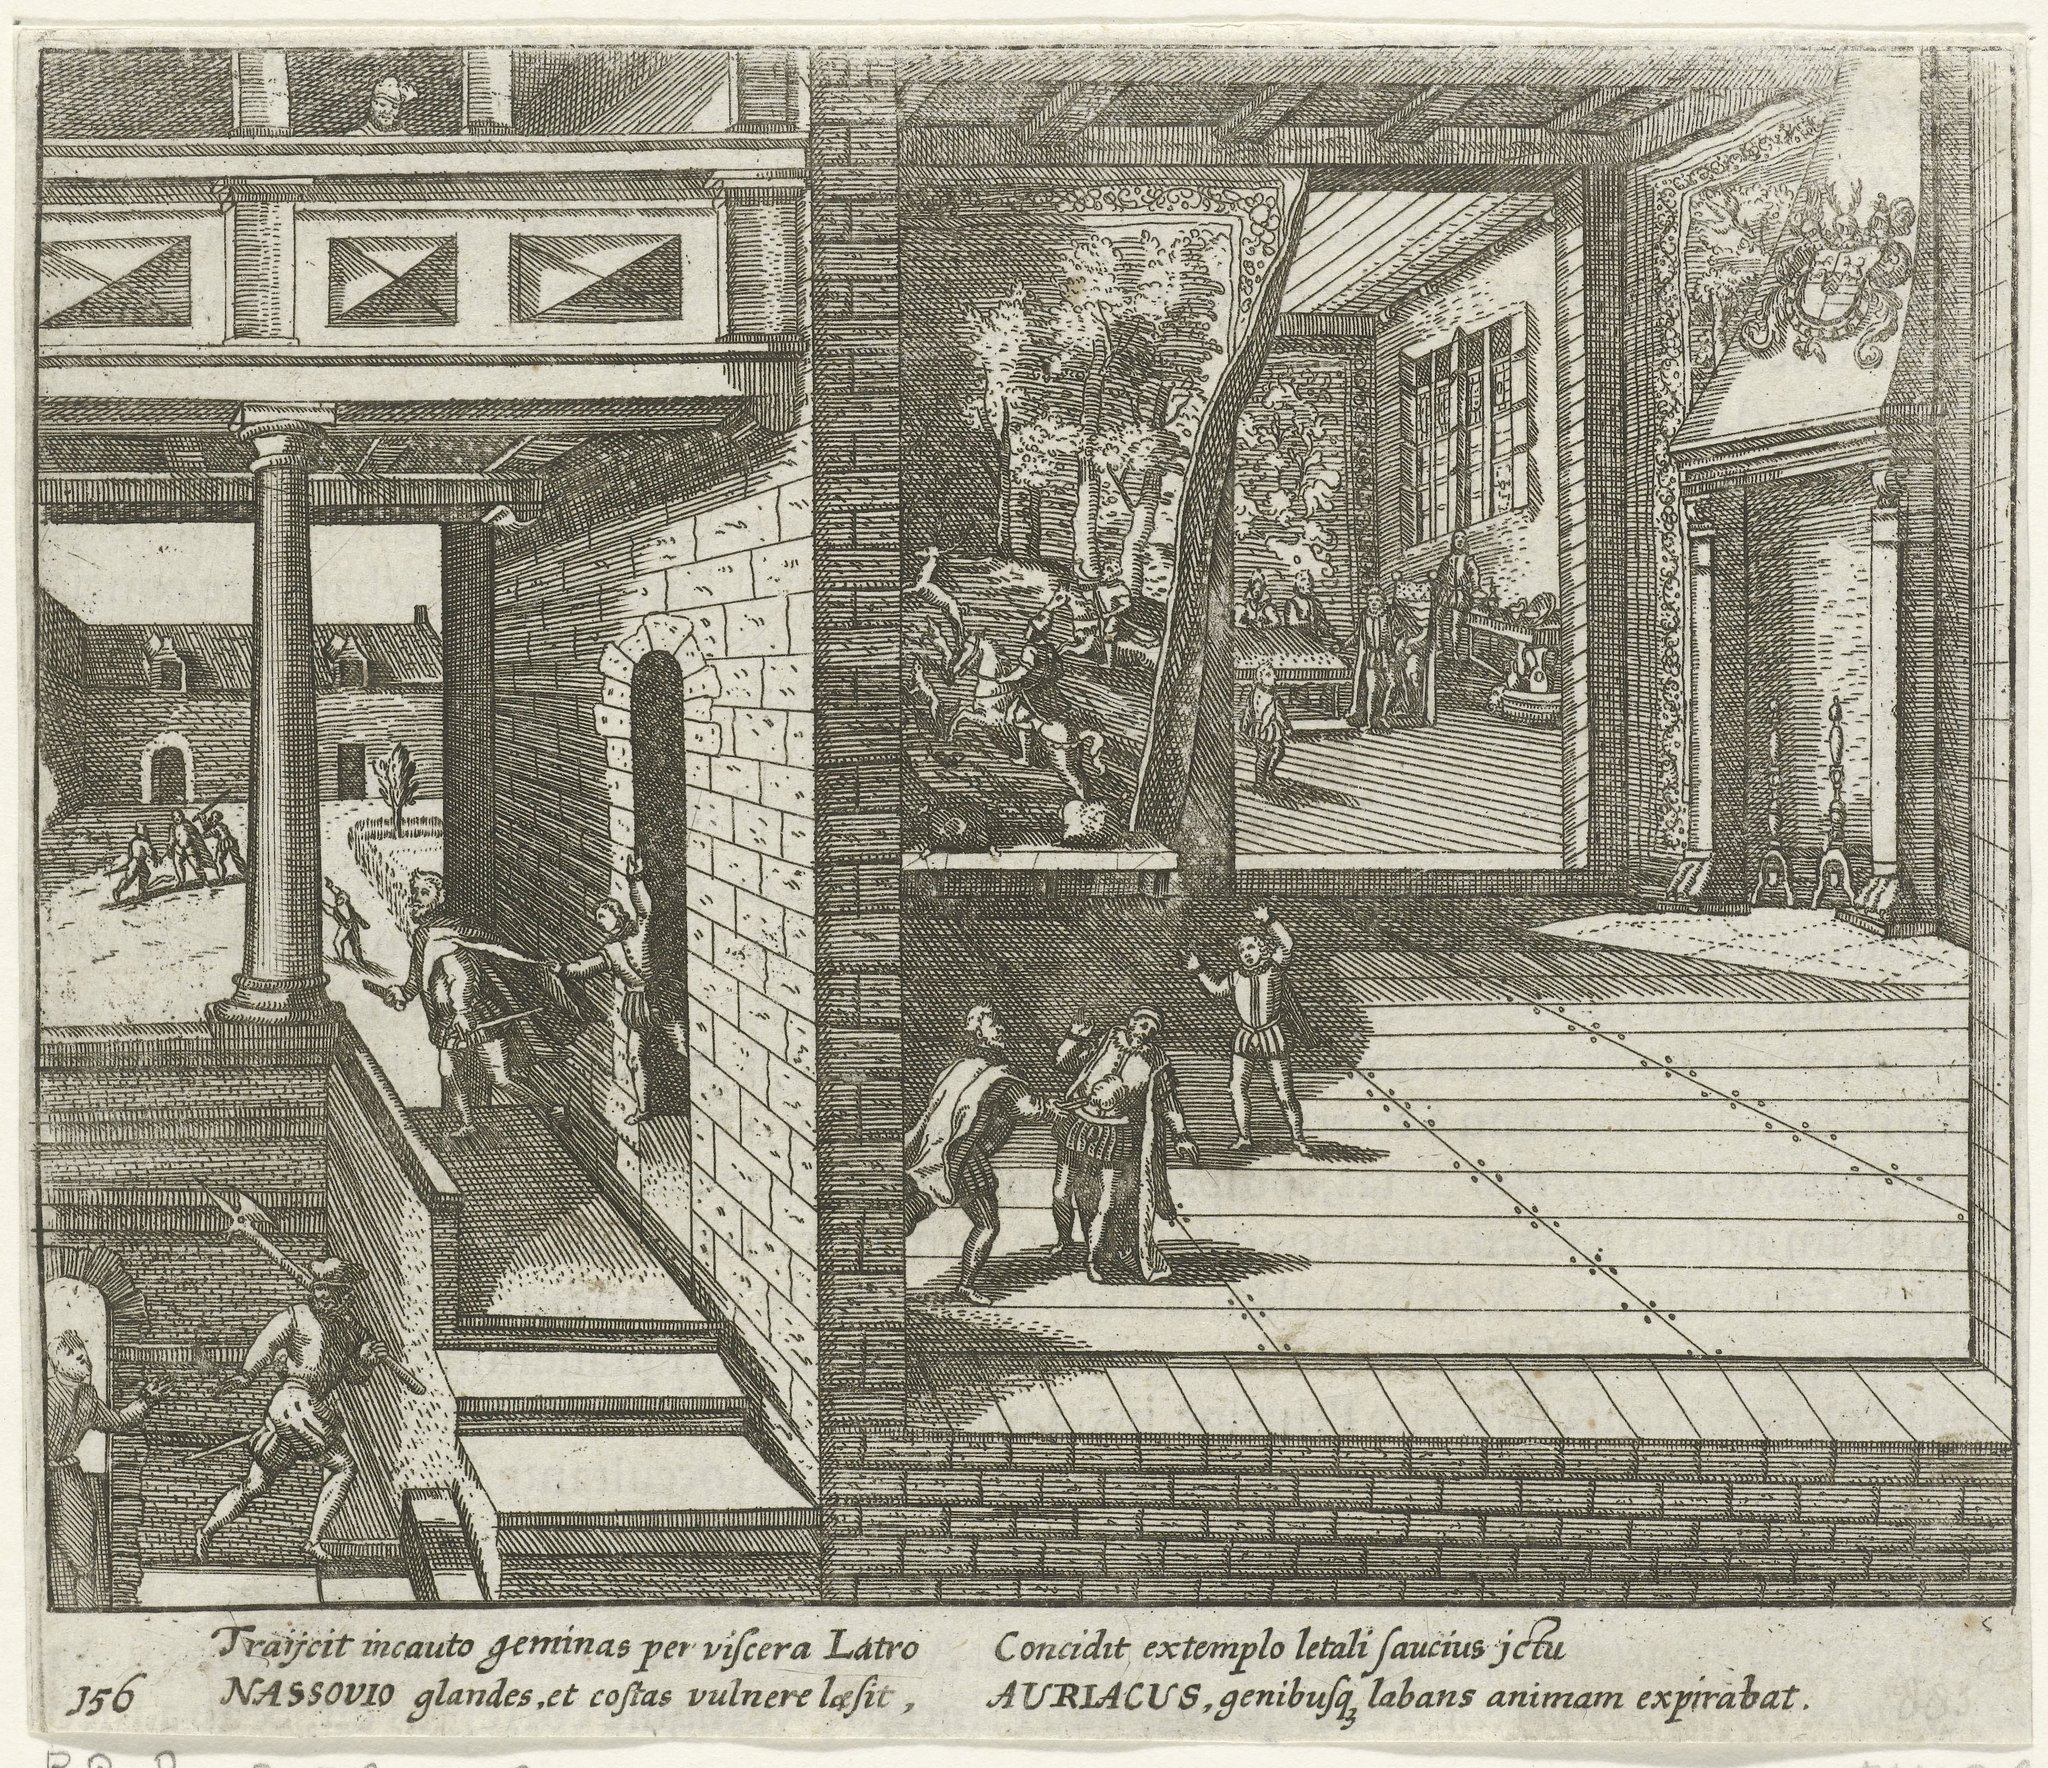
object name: print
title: De moord op Willem van Oranje, 1584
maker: Anonymous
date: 1613-1615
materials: paper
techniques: etching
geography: northern netherlands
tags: delft, william i (prince of orange), attempt, political murder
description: Willem van Oranje vermoord door Balthasar Gerards, 10 juli 1584. Gezicht op interieur Prinsenhof: achter ontvangt de prins Gerards in een kamer, op de voorgrond wordt de prins neergeschoten. Links probeert Gerard te ontsnappen en wordt hij gevangengenomen. Met onderschrift van 4 regels in het Latijn. Genummerd 156. Bedrukt op achterzijde met tekst in het Latijn.